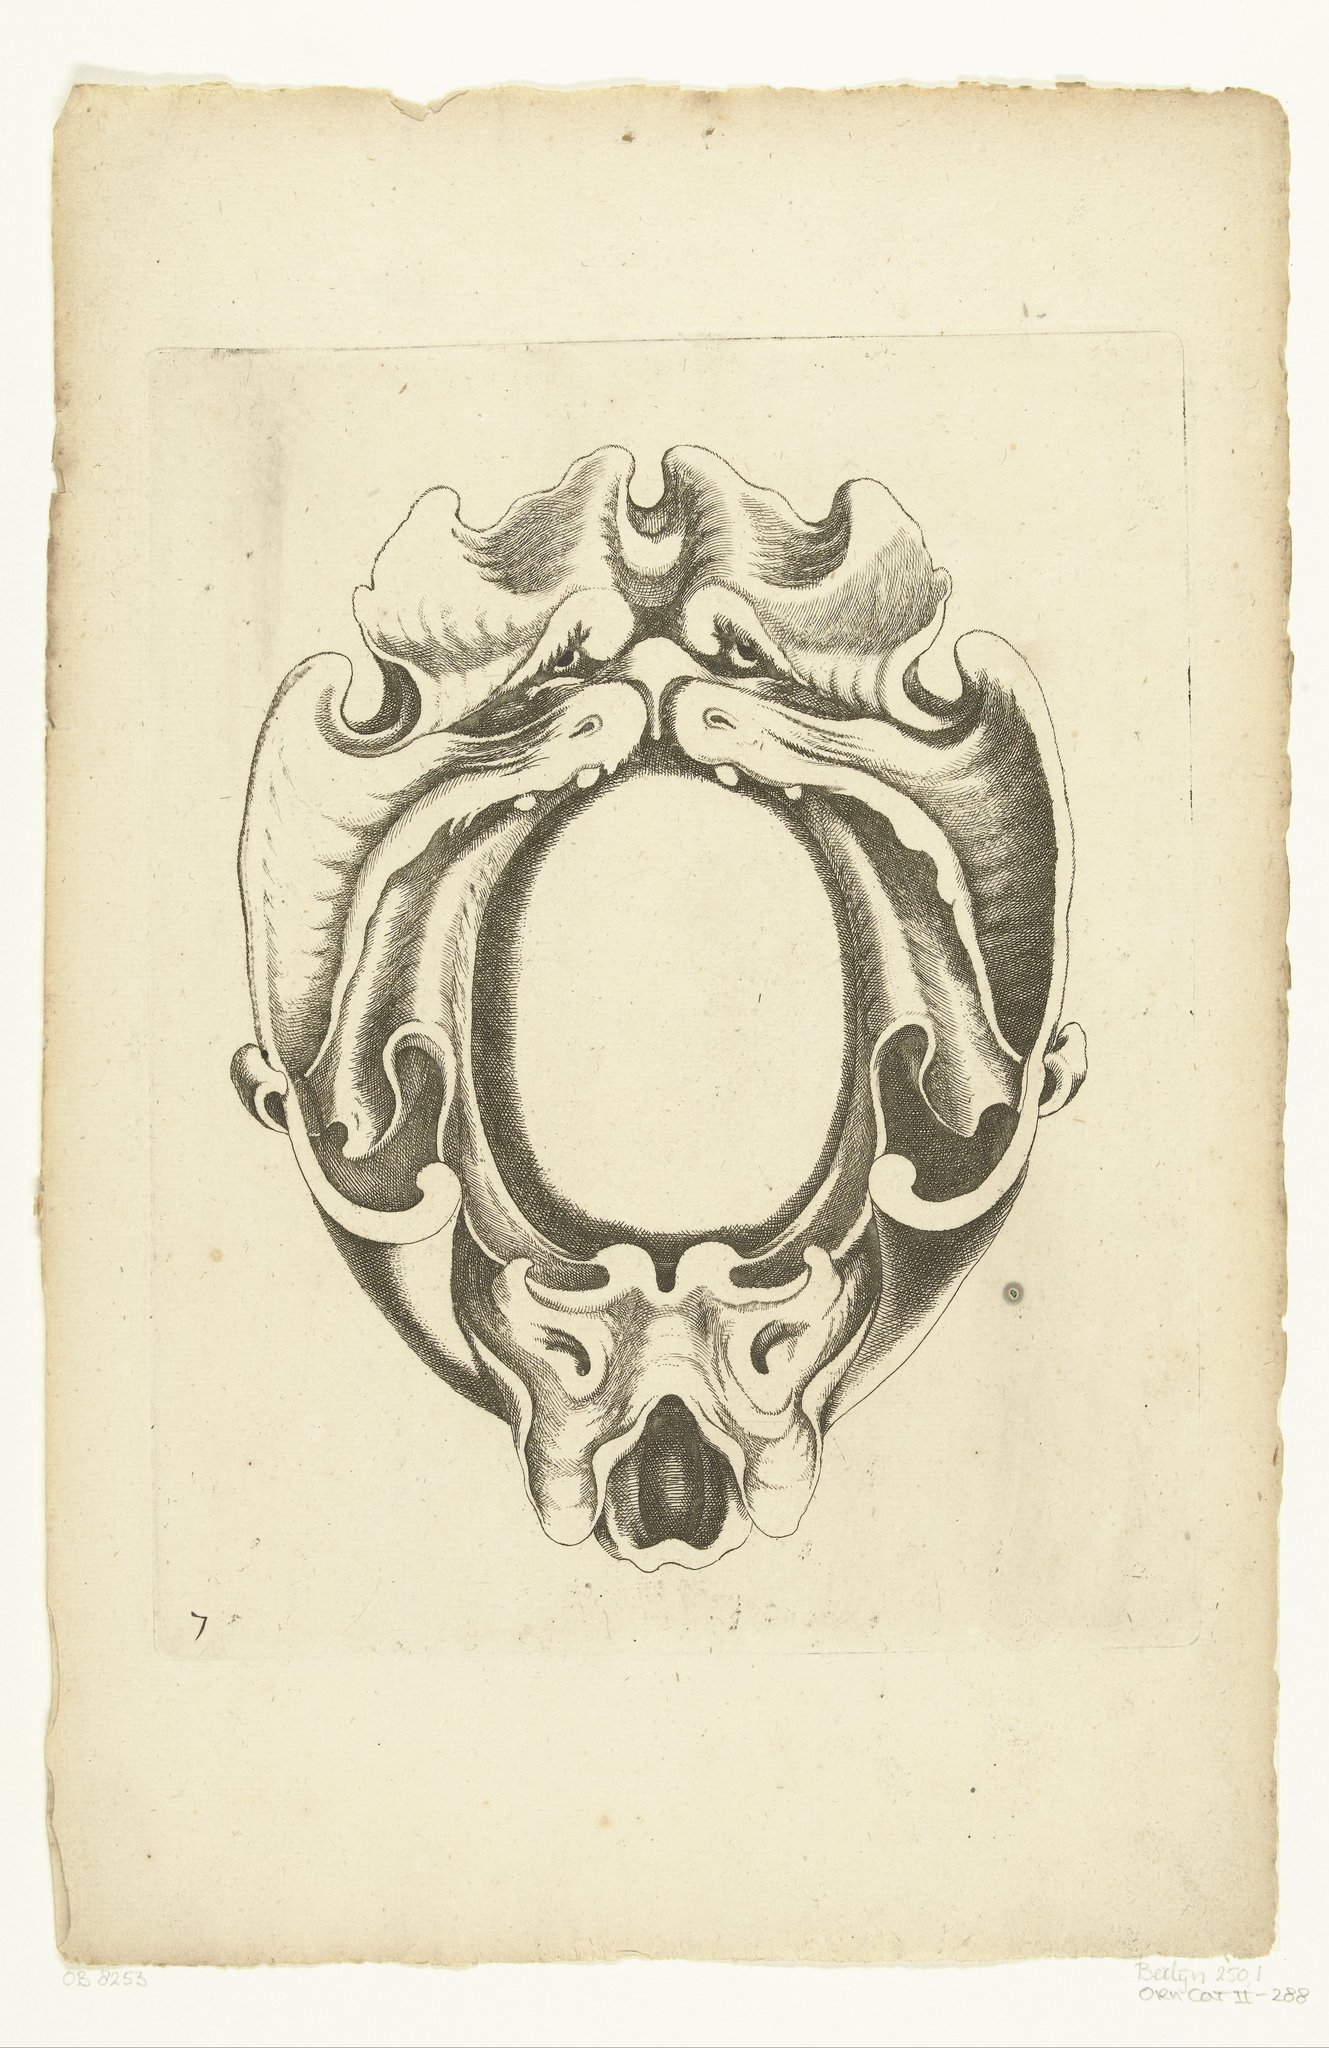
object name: ornament print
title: Cartouche met een groot monsterhoofd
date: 1654-1678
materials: paper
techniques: etching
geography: amsterdam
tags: ornament ~ cartouche, mask, mascaron ~ ornament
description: De gapende bek van het monster vormt het compartiment, onderaan bevindt zich een klein masker.